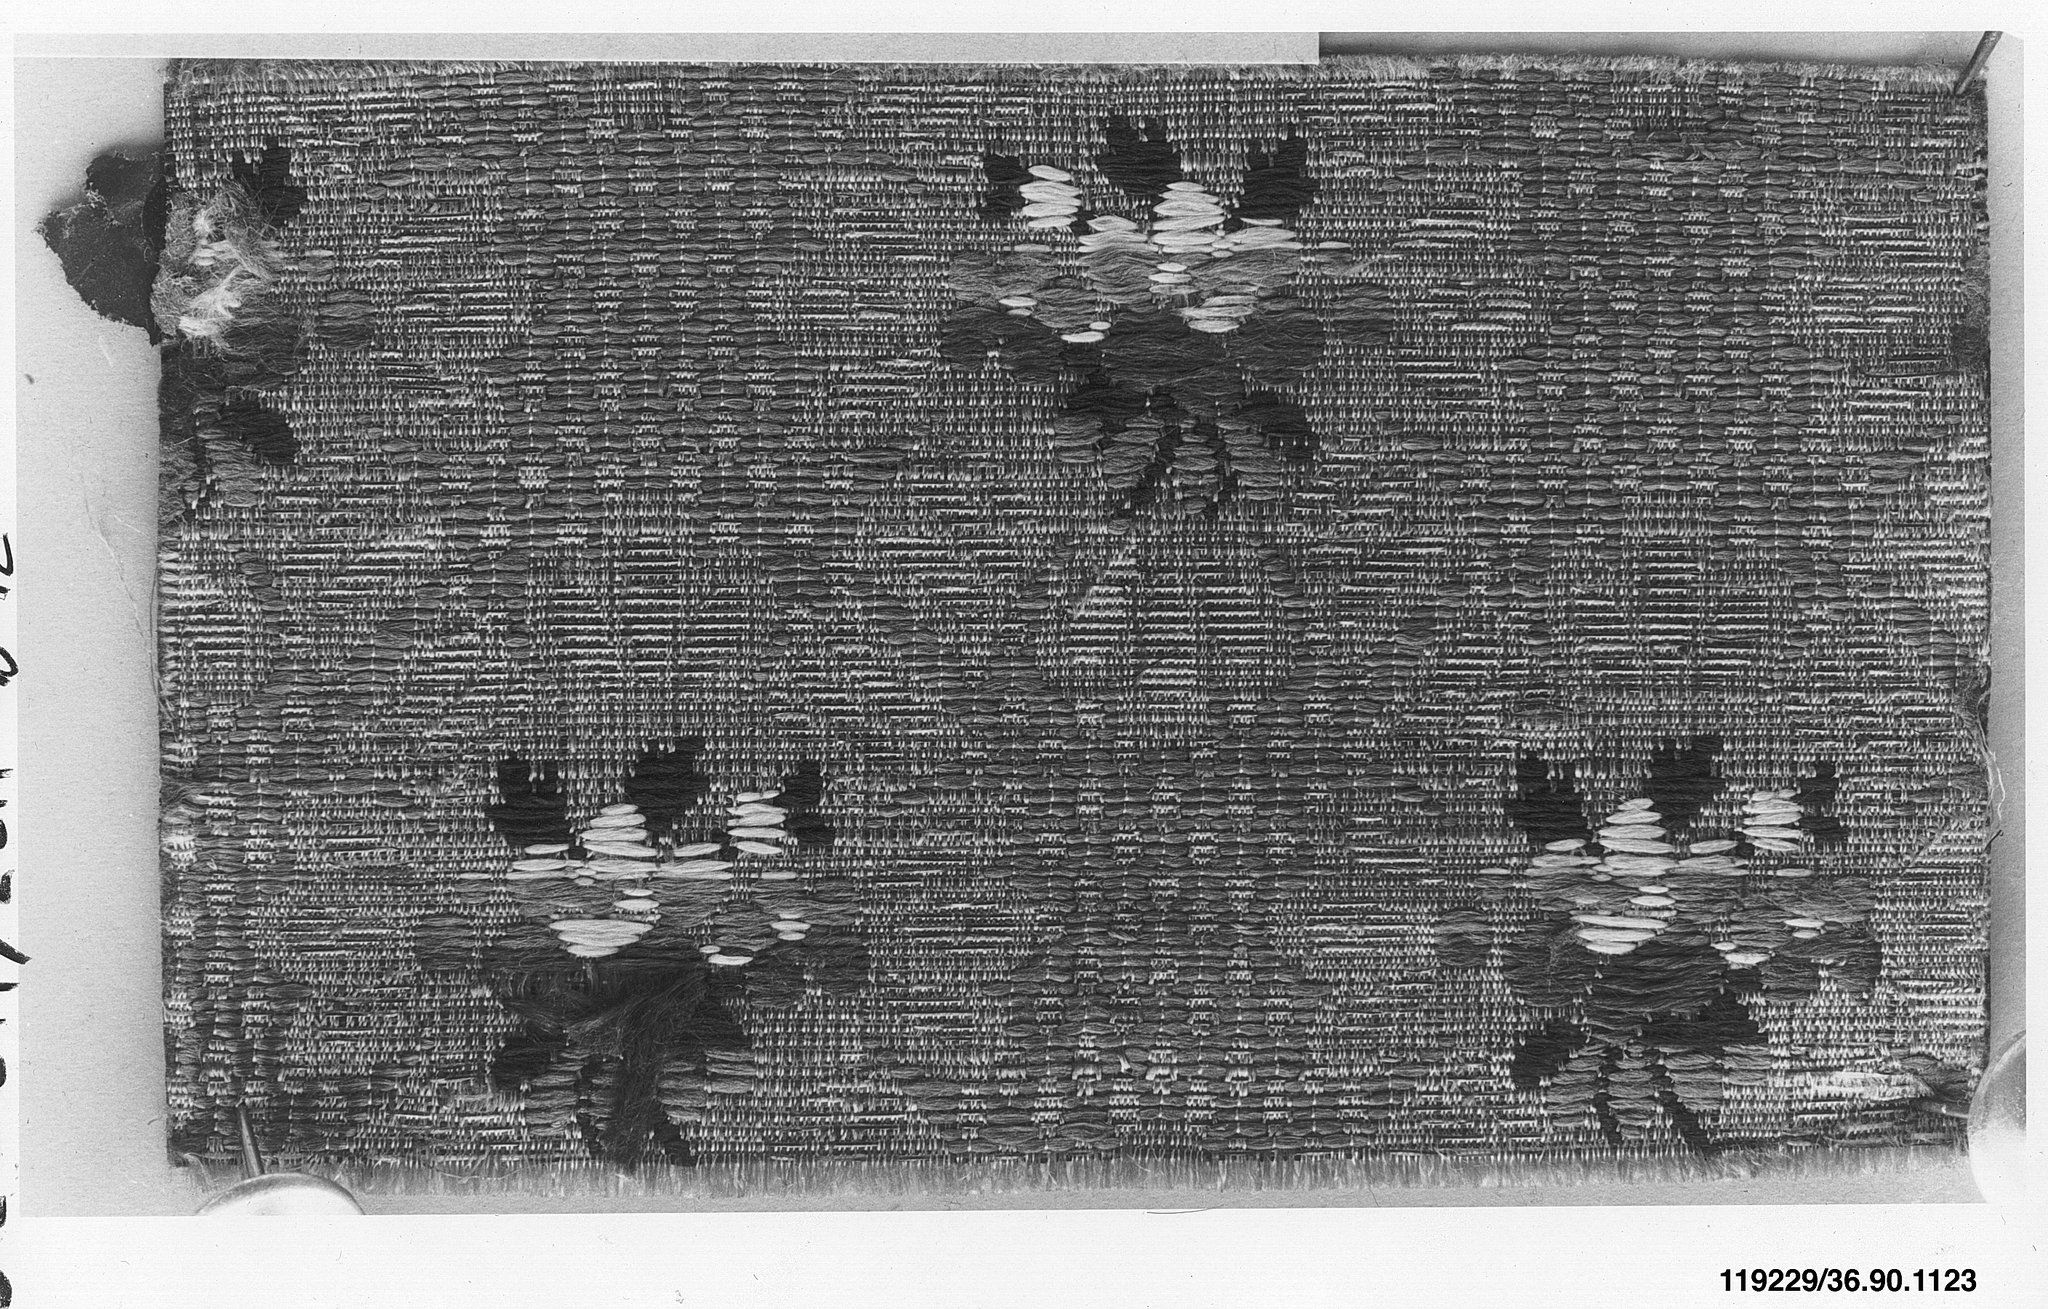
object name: sample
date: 1701-1900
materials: metal thread, silk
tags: flowers